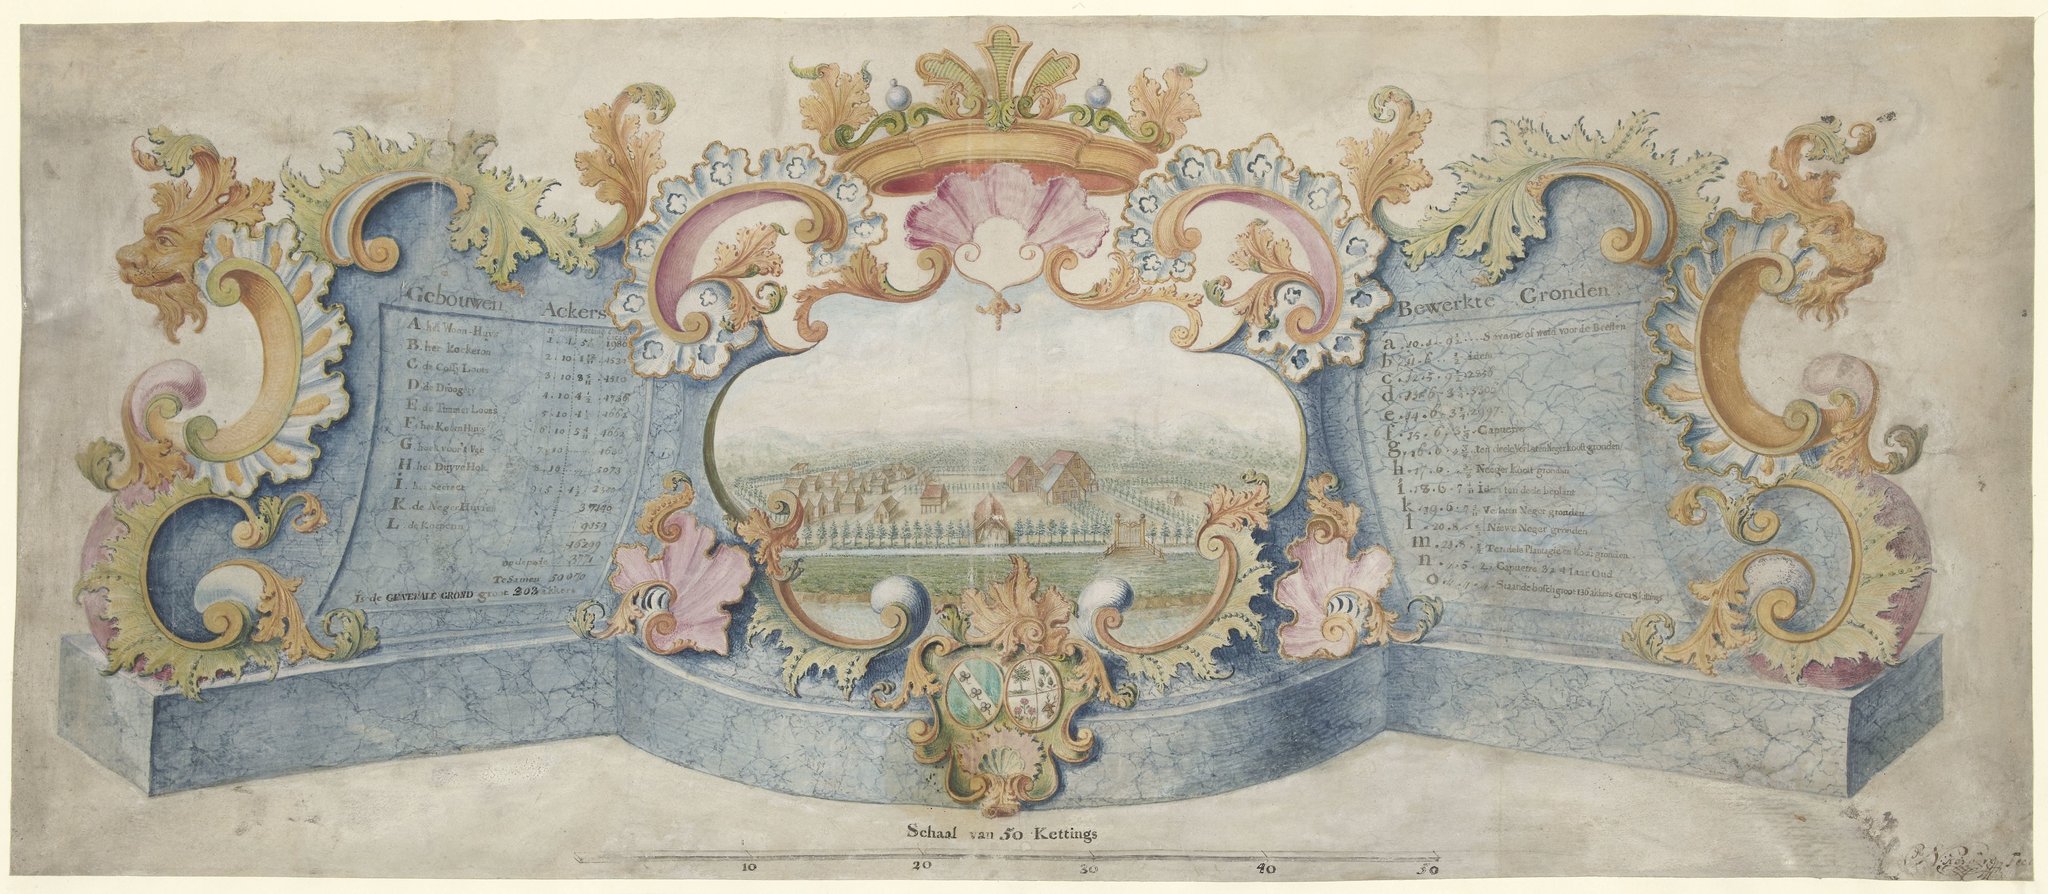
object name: watercolor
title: Fragment van een grote kaart van een West-Indische plantage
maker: n. keiberg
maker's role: draughtsman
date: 1700-1800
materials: ink, parchment, watercolor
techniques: brush, pen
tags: plantation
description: Fragment van een grote kaart van een West-Indische plantage, met verklaring der letters, een overzichtstekening, een alliantiewapen en ornamentaal bijwerk.